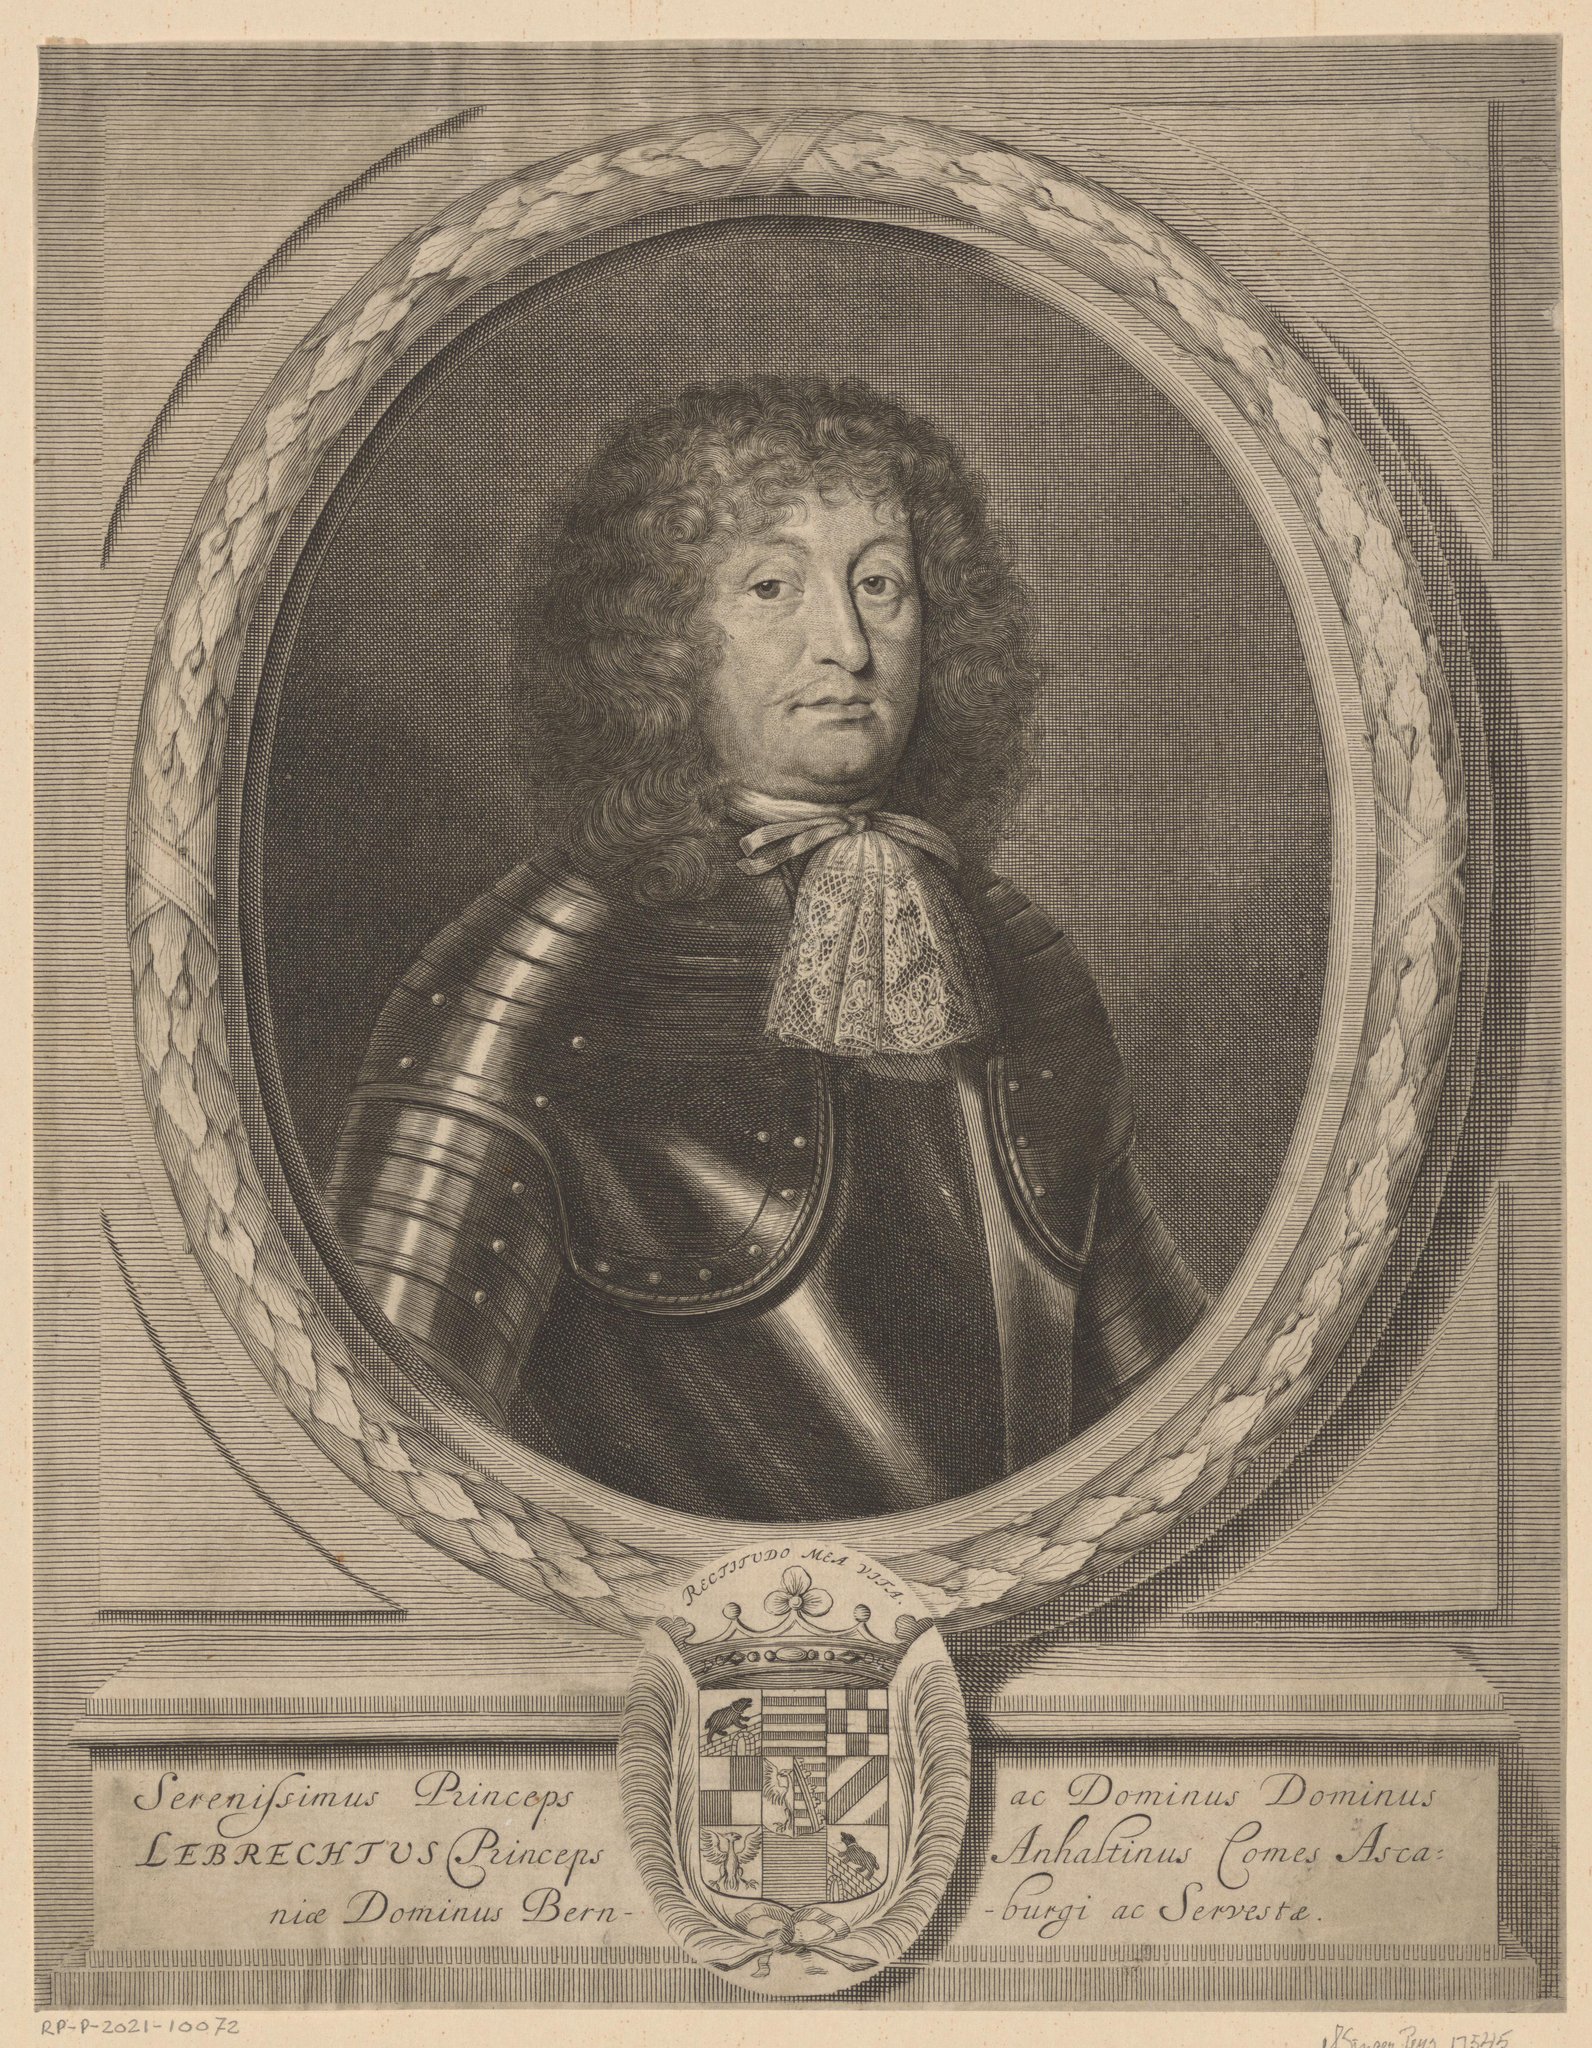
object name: print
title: Portret van Lebrecht von Anhalt-Köthen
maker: Anonymous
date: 1650-1699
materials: paper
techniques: engraving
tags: historical persons, armorial bearing, heraldry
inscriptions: collector's mark: Lugt 2228